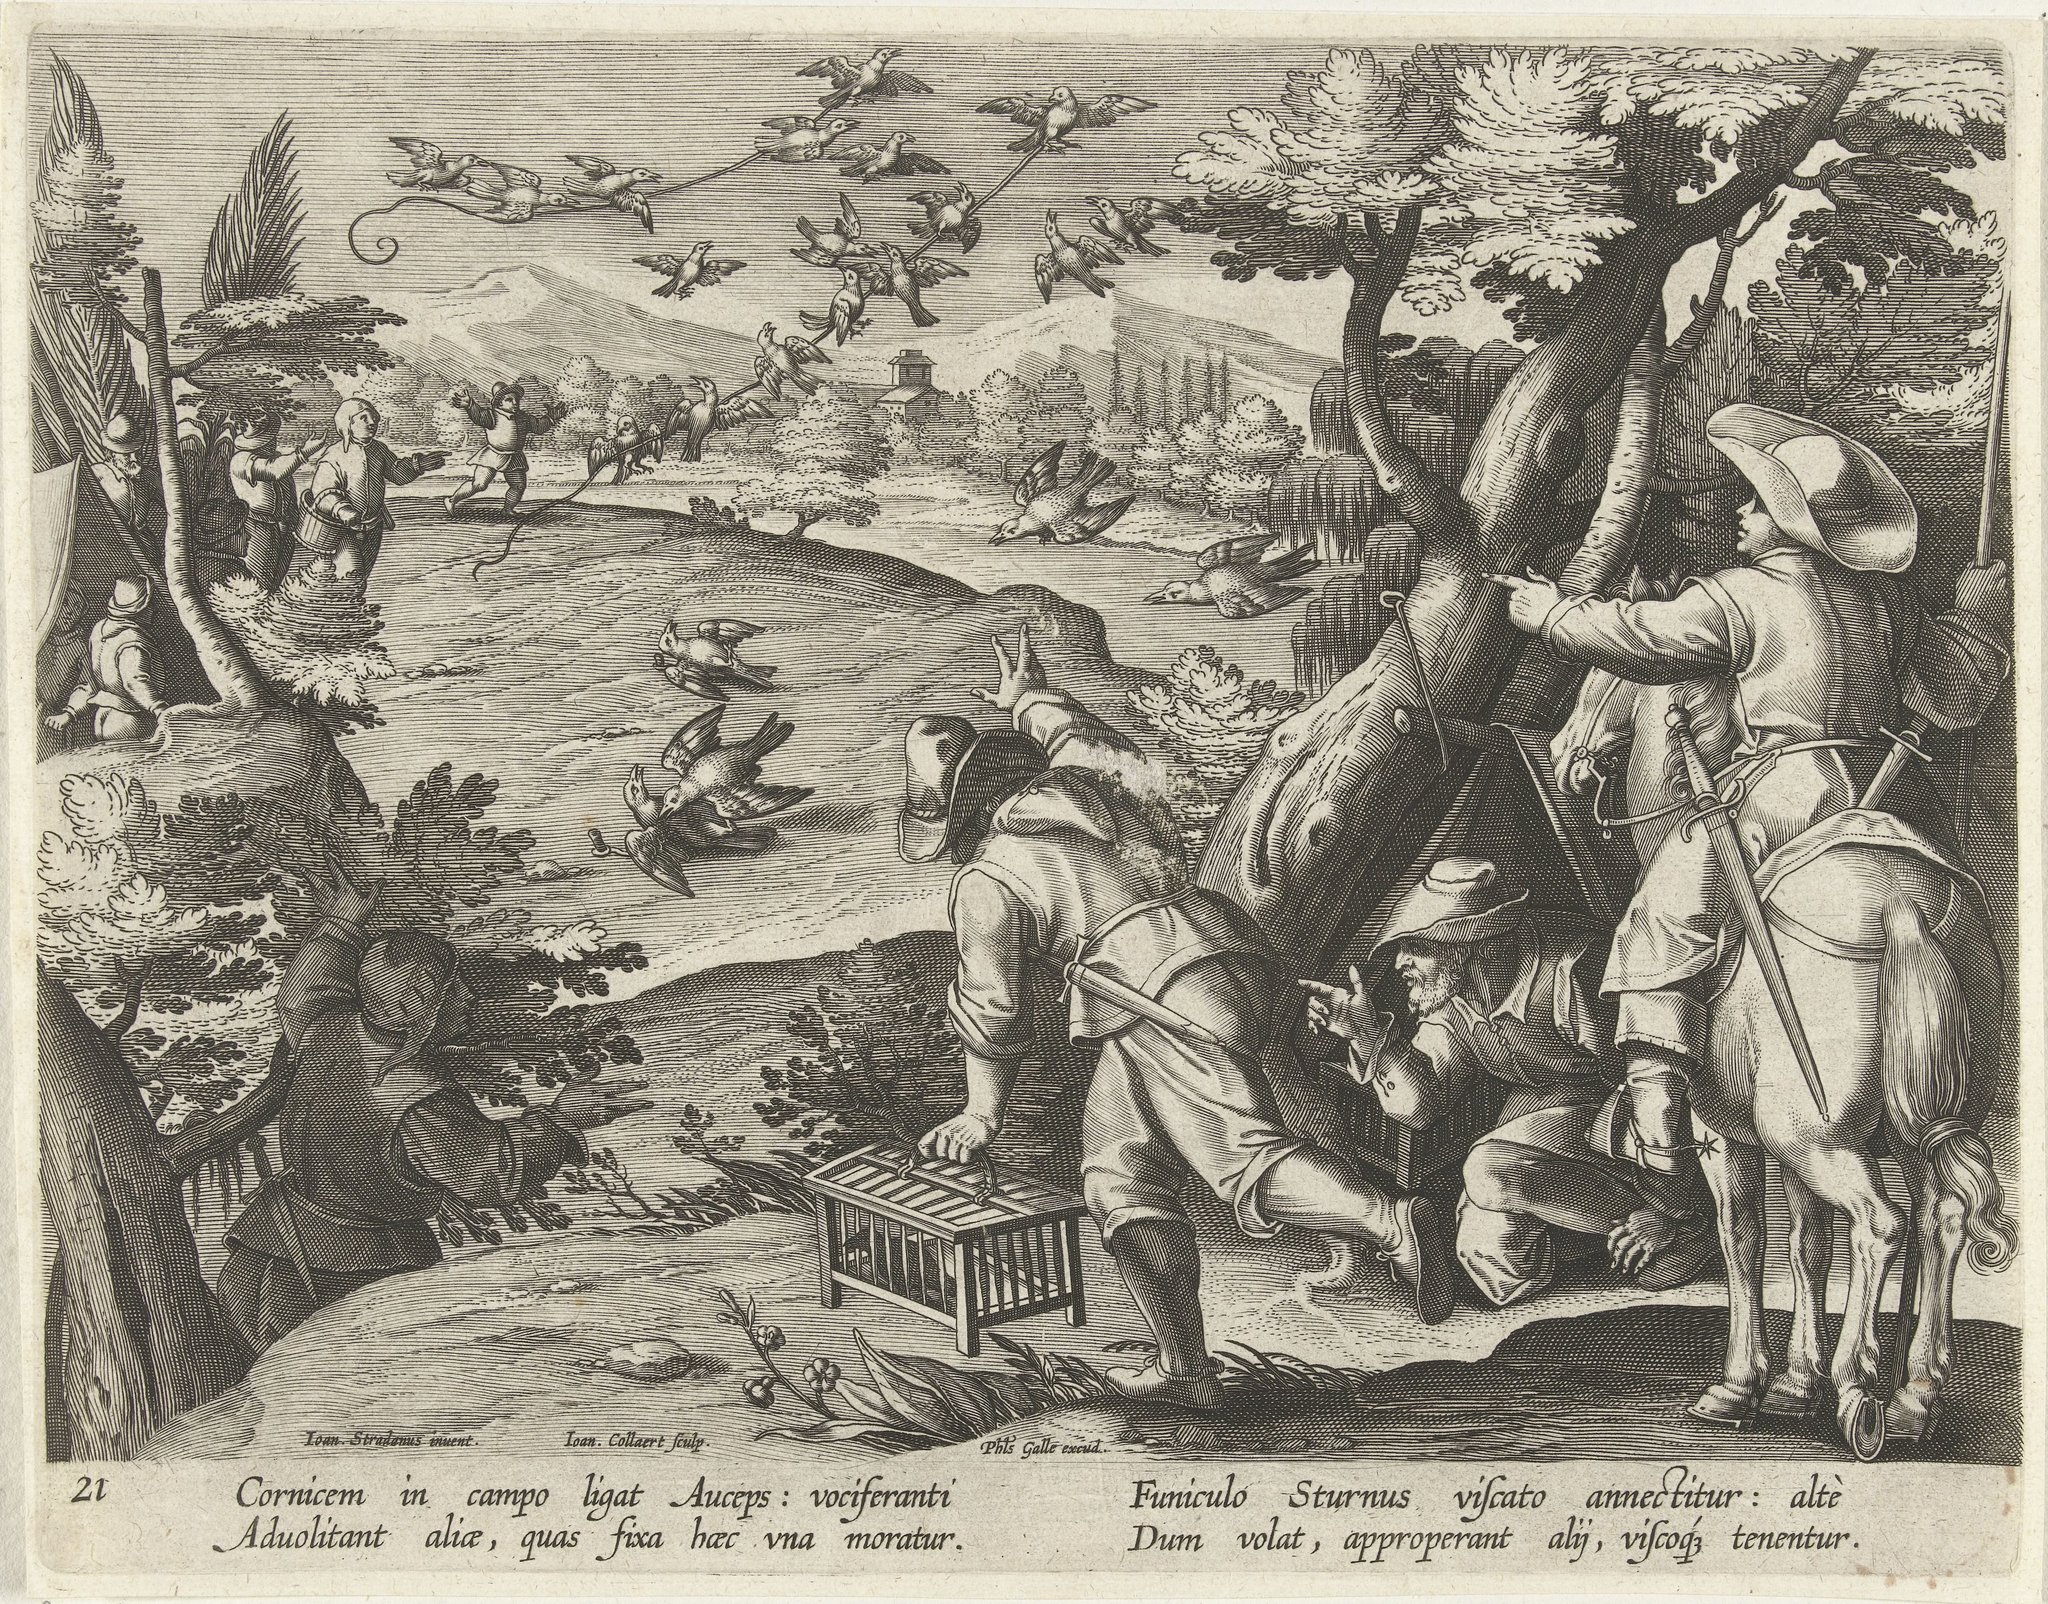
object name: print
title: Jacht op kraaien en spreeuwen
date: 1594-1598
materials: paper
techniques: engraving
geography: florence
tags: song-birds: crow, bird hunting, song-birds: starling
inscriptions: collector's mark: Lugt 240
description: Twee manieren om vogels te vangen. Op de voorgrond zijn twee kraaien vastgebonden aan de grond. Hun gekras trekt soortgenoten aan, die vervolgens worden gevangen. In de lucht vliegt een spreeuw aan een touw. Andere spreeuwen vliegen naar hem toe en komen vast te zitten aan het touw, dat met vogellijm is besmeerd. De prent heeft een Latijns onderschrift en is deel van een serie over jachttaferelen.